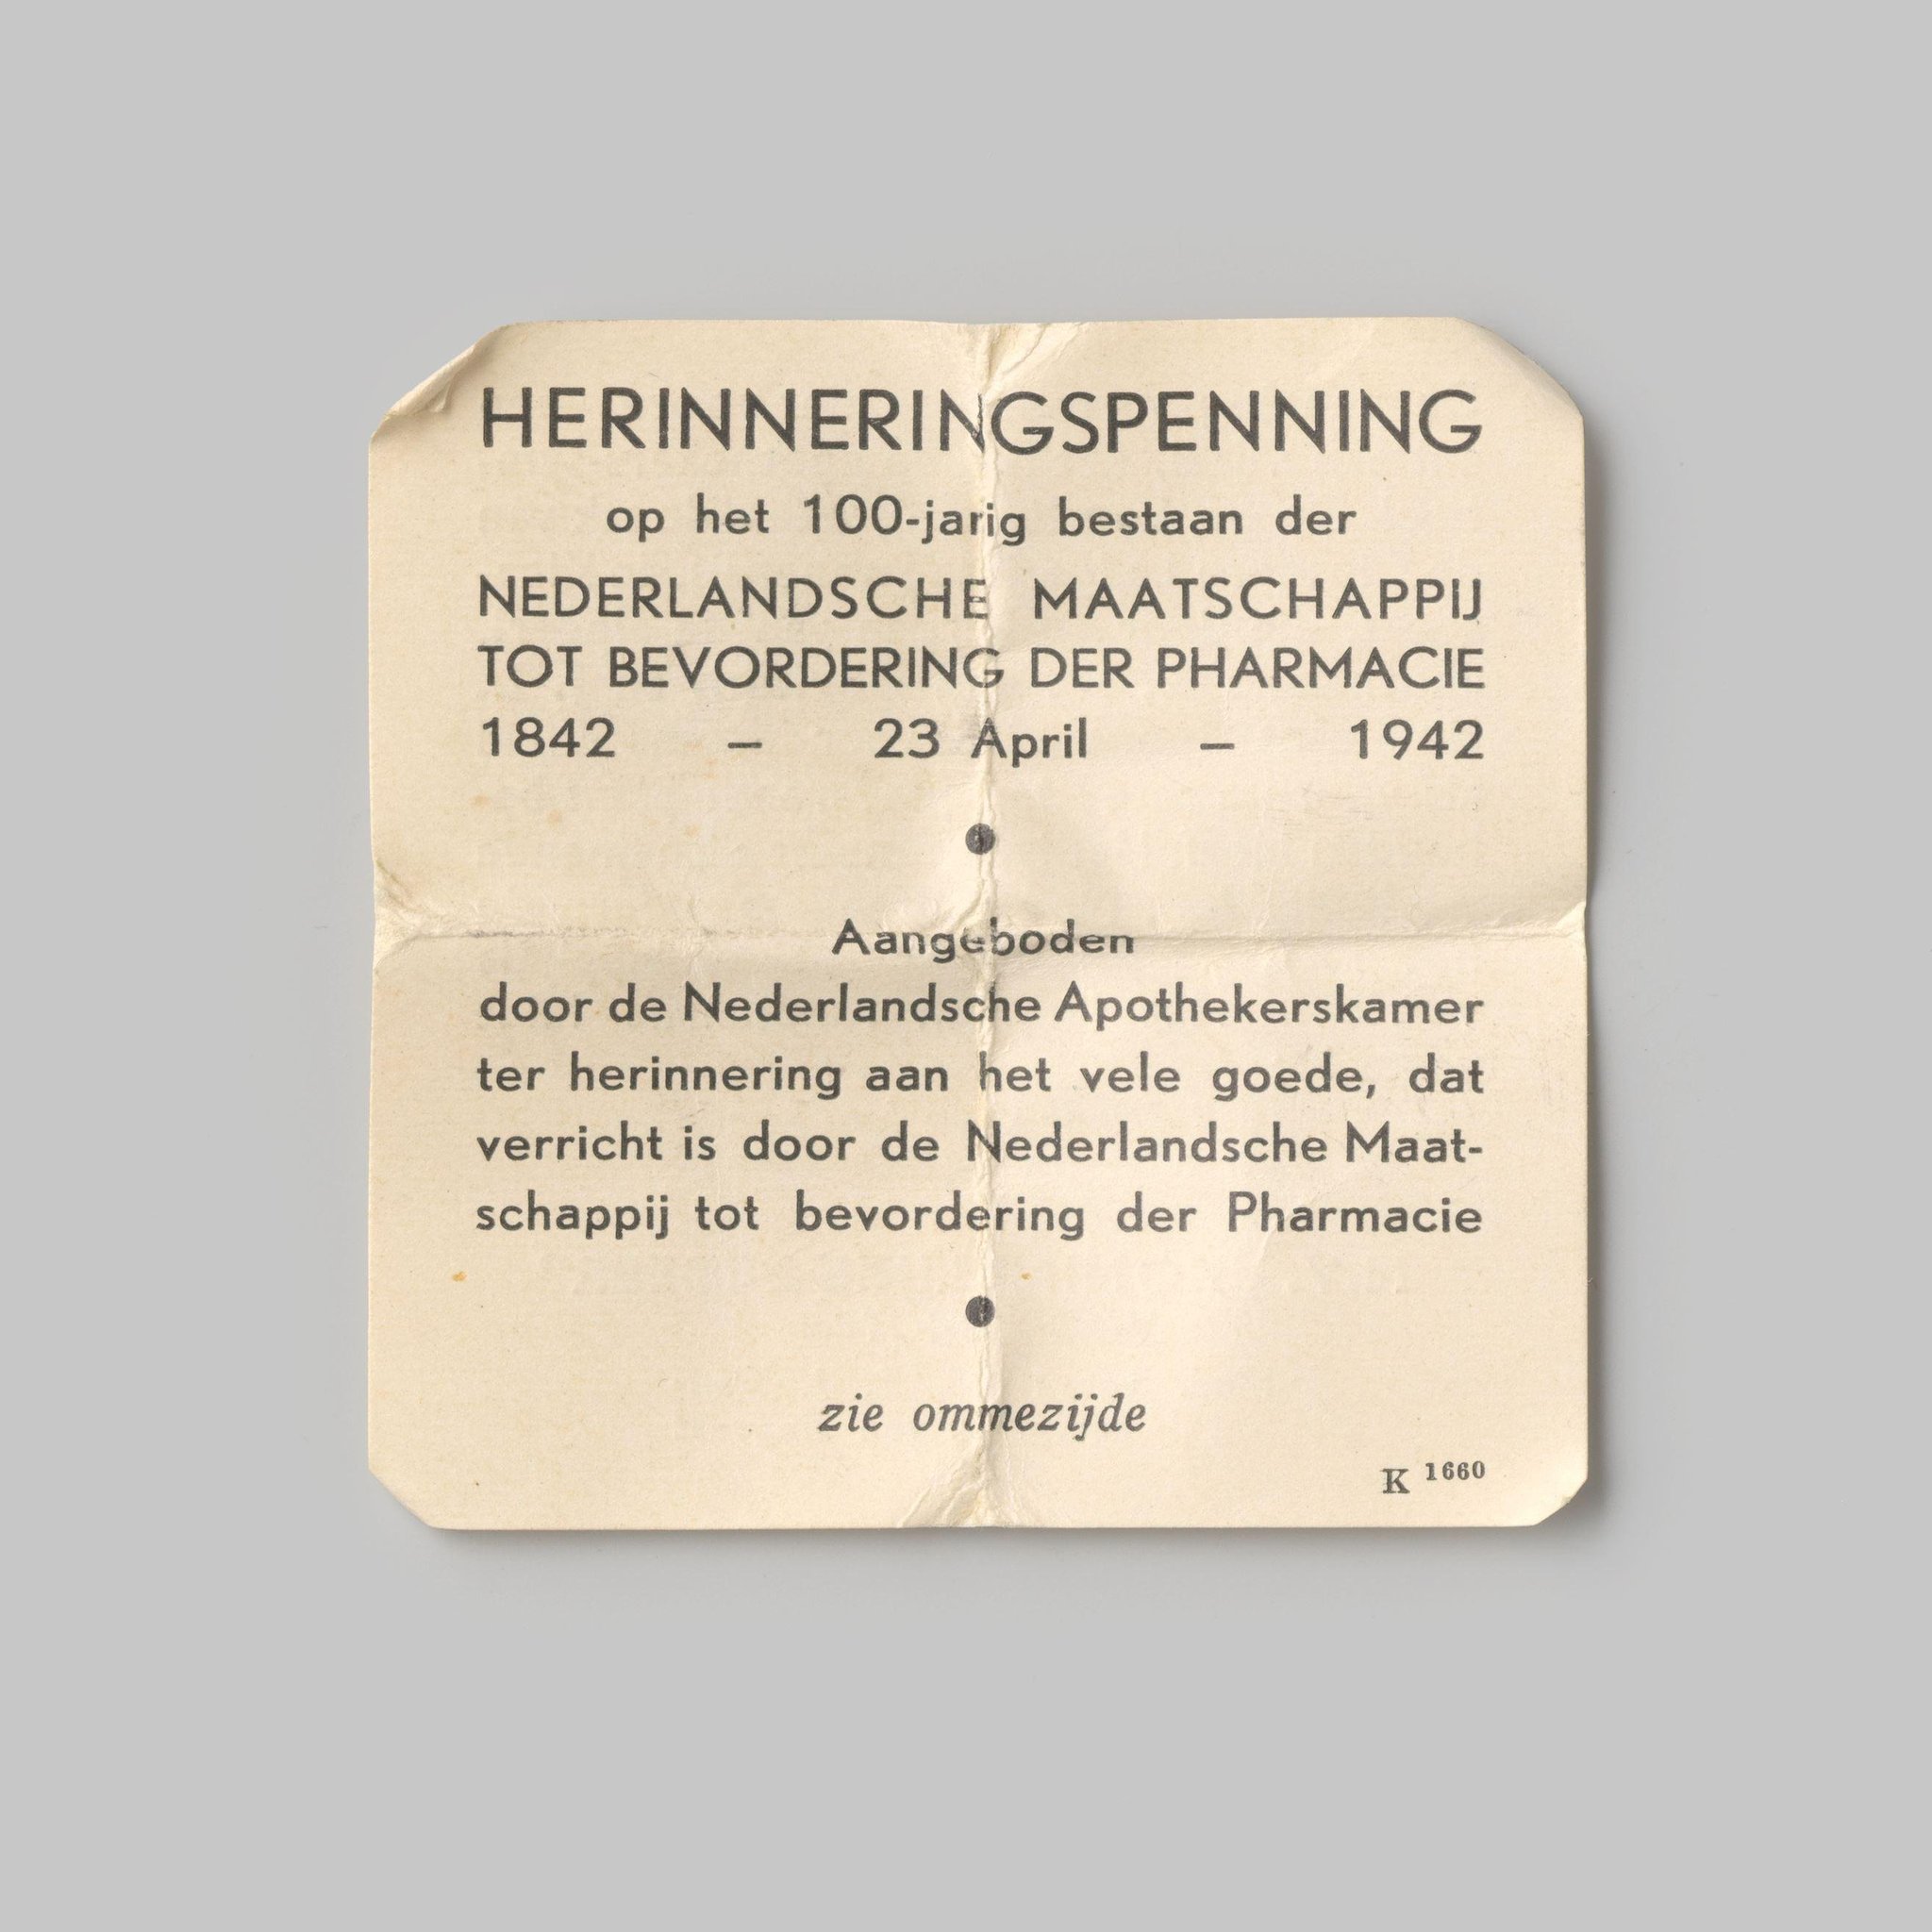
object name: paper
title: Beschrijving bij penning 100-jarig bestaan der Nederlandsche Maatschappij tot bevordering der pharmacie 1842 - 1942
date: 1942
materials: paper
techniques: folding, printing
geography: voorschoten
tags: koninklijke nederlandse maatschappij ter bevordering der pharmacie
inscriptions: inscription: ‘De penning vertoon op de voorz. een antieke vijzel, het aloude apothekers-sym- bool. Op de keerz. is afgebeeld de tak van de Cinchona Ledgeriana Javanensis, de Kina- soort, die door de zorgen van de Nederl. apothekers K. W. van Gorkom en J. L. Bernelot Moens in 1865 voor de menschheid als voornaamste Kinine-leverende plant be- houden bleef. Het is het meest uitnemende werk, dat door Ned. apothekers gedurende het 100-jarig bestaan der Maatschappij is verricht. Het latijnsch randschrift luidt vertaald: "Zij dienen door hun kunde en nauwgezette toewijding" Ontwerp en uitvoering: N.V. "KONINKLIJKE-BEGEER" VOORSCHOTEN Mod. voorz. M. P. J. Fleur ,, keerz. P. van Zegveld’, inscription: ‘HERINNERINGSPENNING op het 100-jarig bestaan der NEDERLANDSCHE MAATSCHAPPIJ TOT BEVORDERING DER PHARMACIE 1842 - 23 April - 1942 . Aangeboden door de Nederlandsche Apothekerskamer ter herinnering aan het vele goede, dat verricht is door de Nederlandsche Maat- schappij tot bevordering der Pharmacie . zie ommezijde K1660’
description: Vierkante beschrijving van penning, tweezijdig bedrukt in zwart.